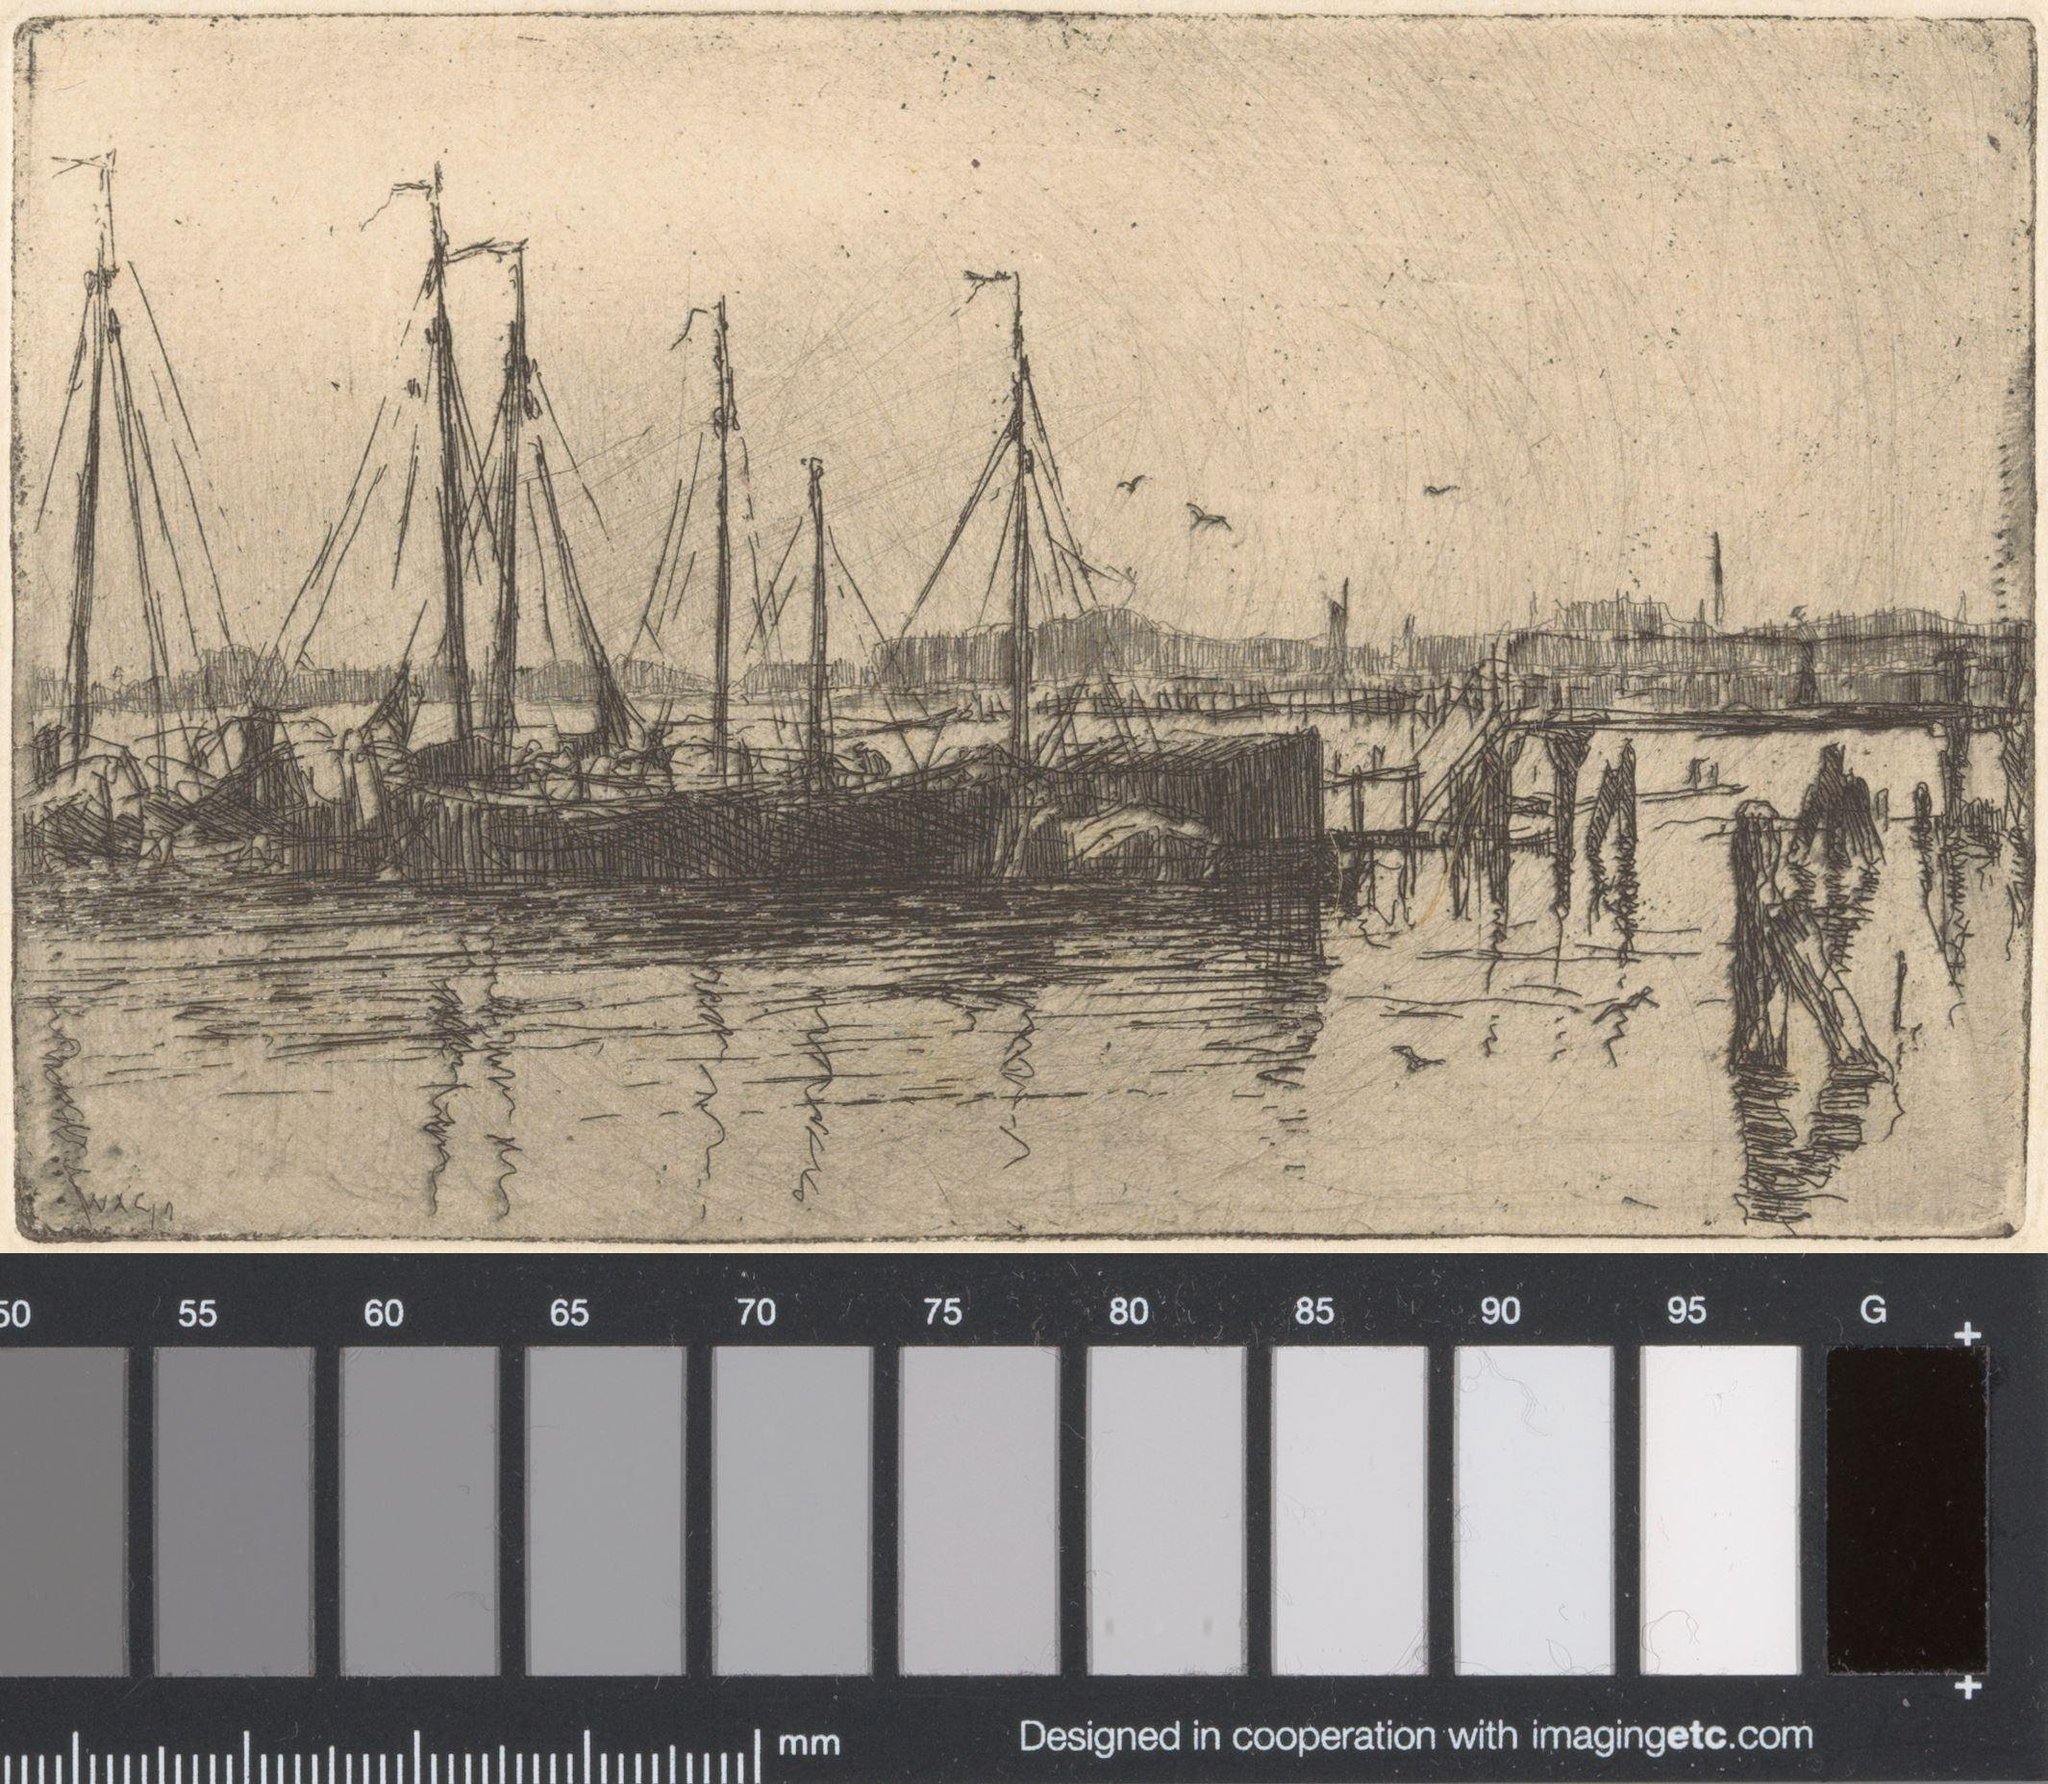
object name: print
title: Op 't IJ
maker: willem adrianus grondhout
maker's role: draughtsman, painter, print maker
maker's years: 1878-1934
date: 1888-1934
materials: paper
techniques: etching, intaglio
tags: harbour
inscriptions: collector's mark: Lugt 2228